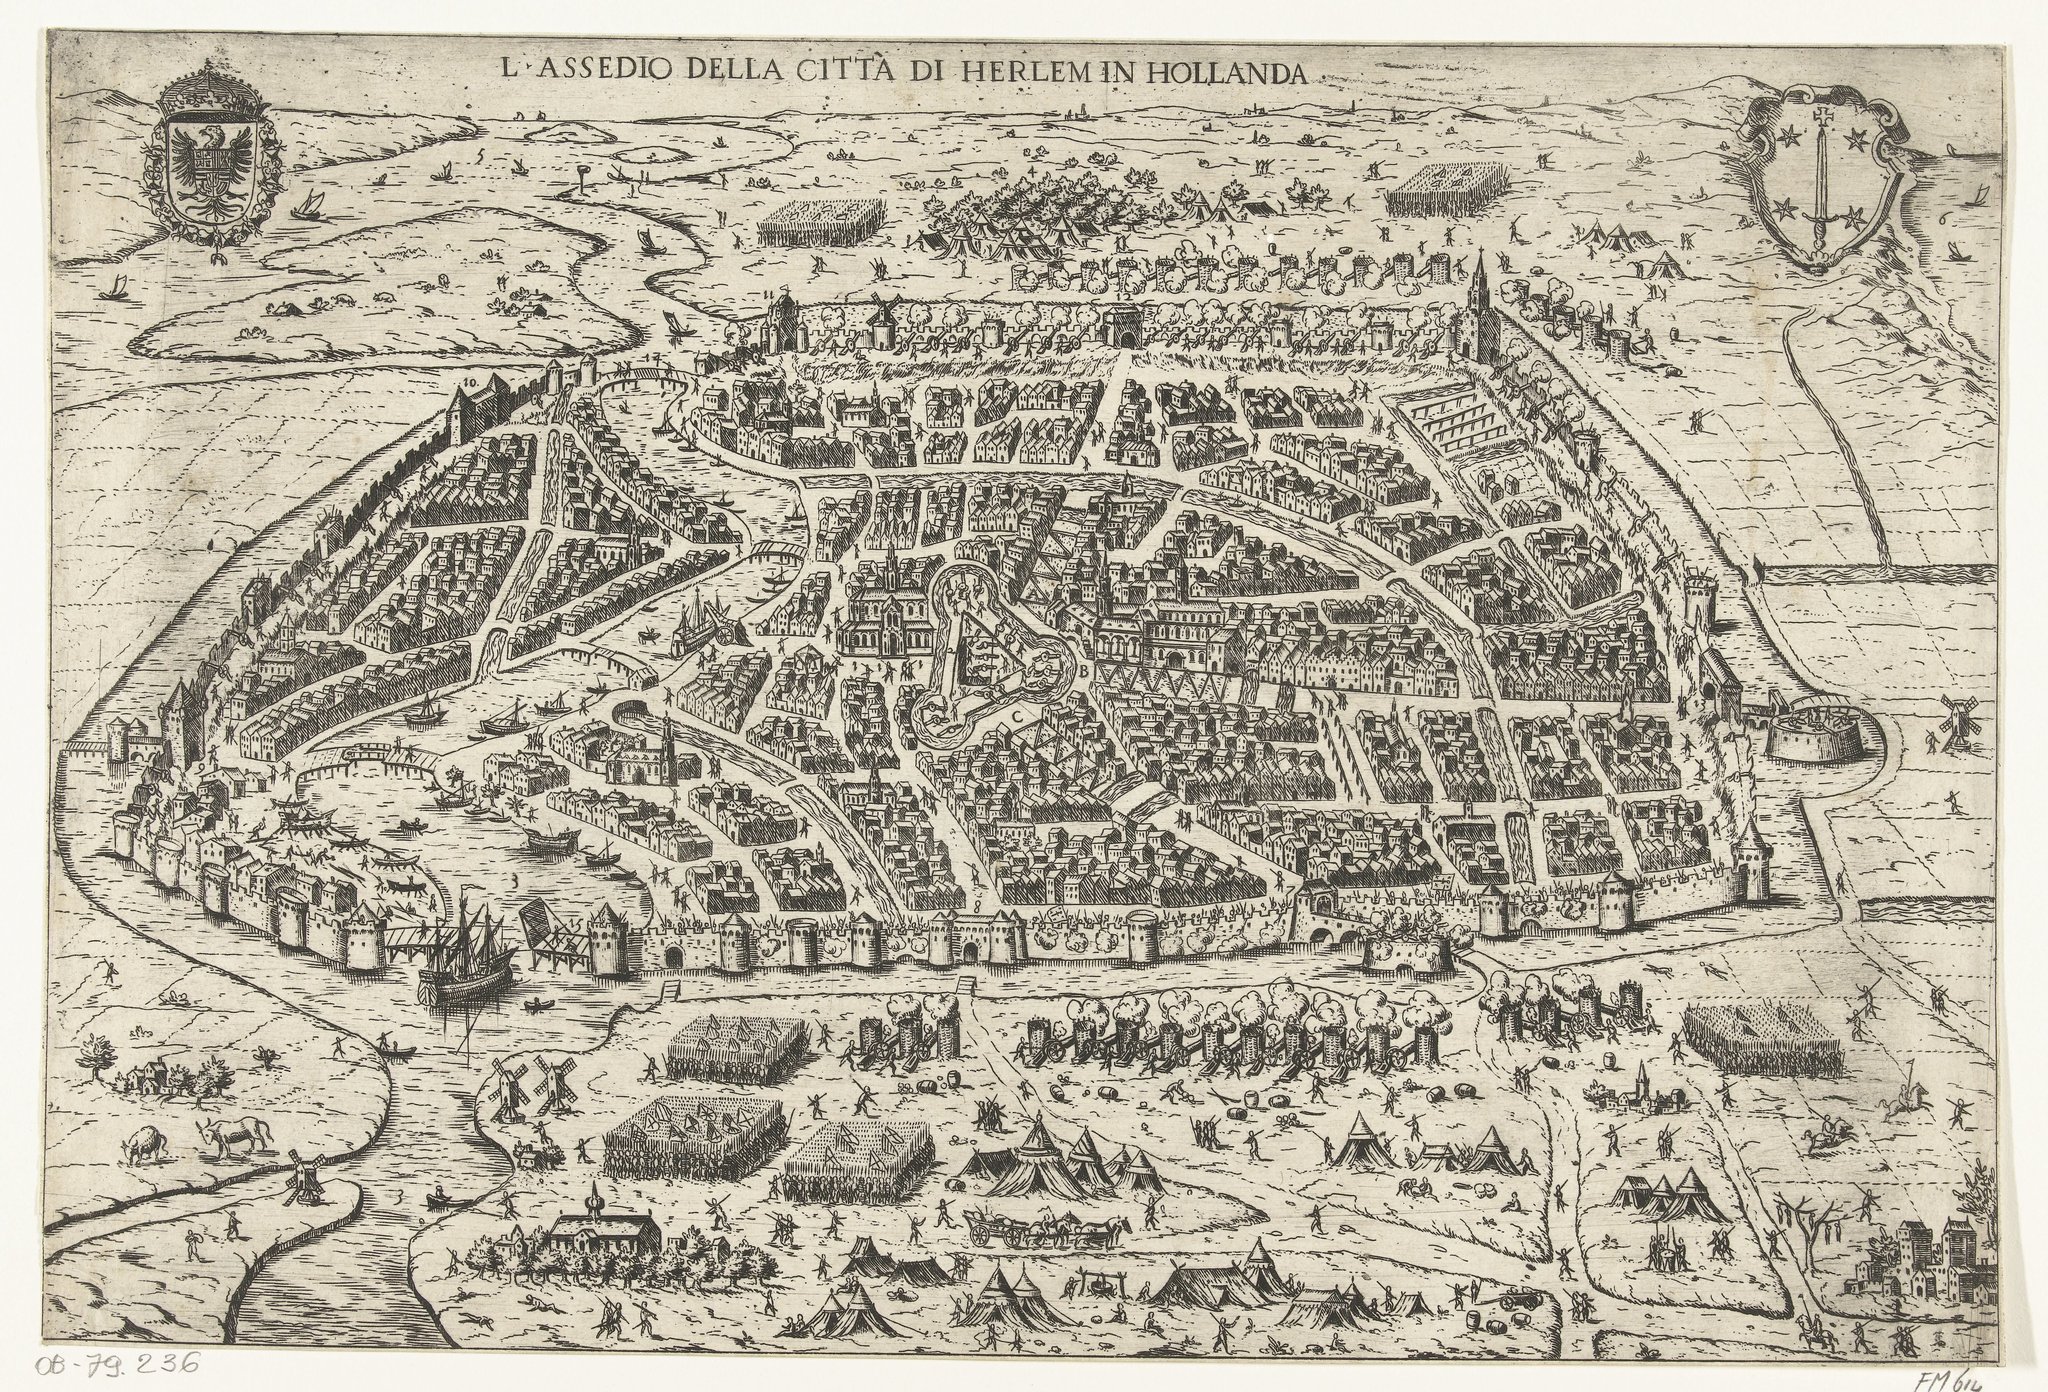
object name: print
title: L'Assedio della città di Herlem in Hollanda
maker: antonio lafreri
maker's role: publisher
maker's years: 1512-1577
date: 1573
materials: paper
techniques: etching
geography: rome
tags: siege, position war, haarlem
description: Overzicht van het beleg van de stad Haarlem in vogelvluchtperspectief. Op de voorgrond en bovenaan de legerplaatsen van de Spaanse troepen. Bovenaan wapens van het Duitse keizerrijk en Haarlem.